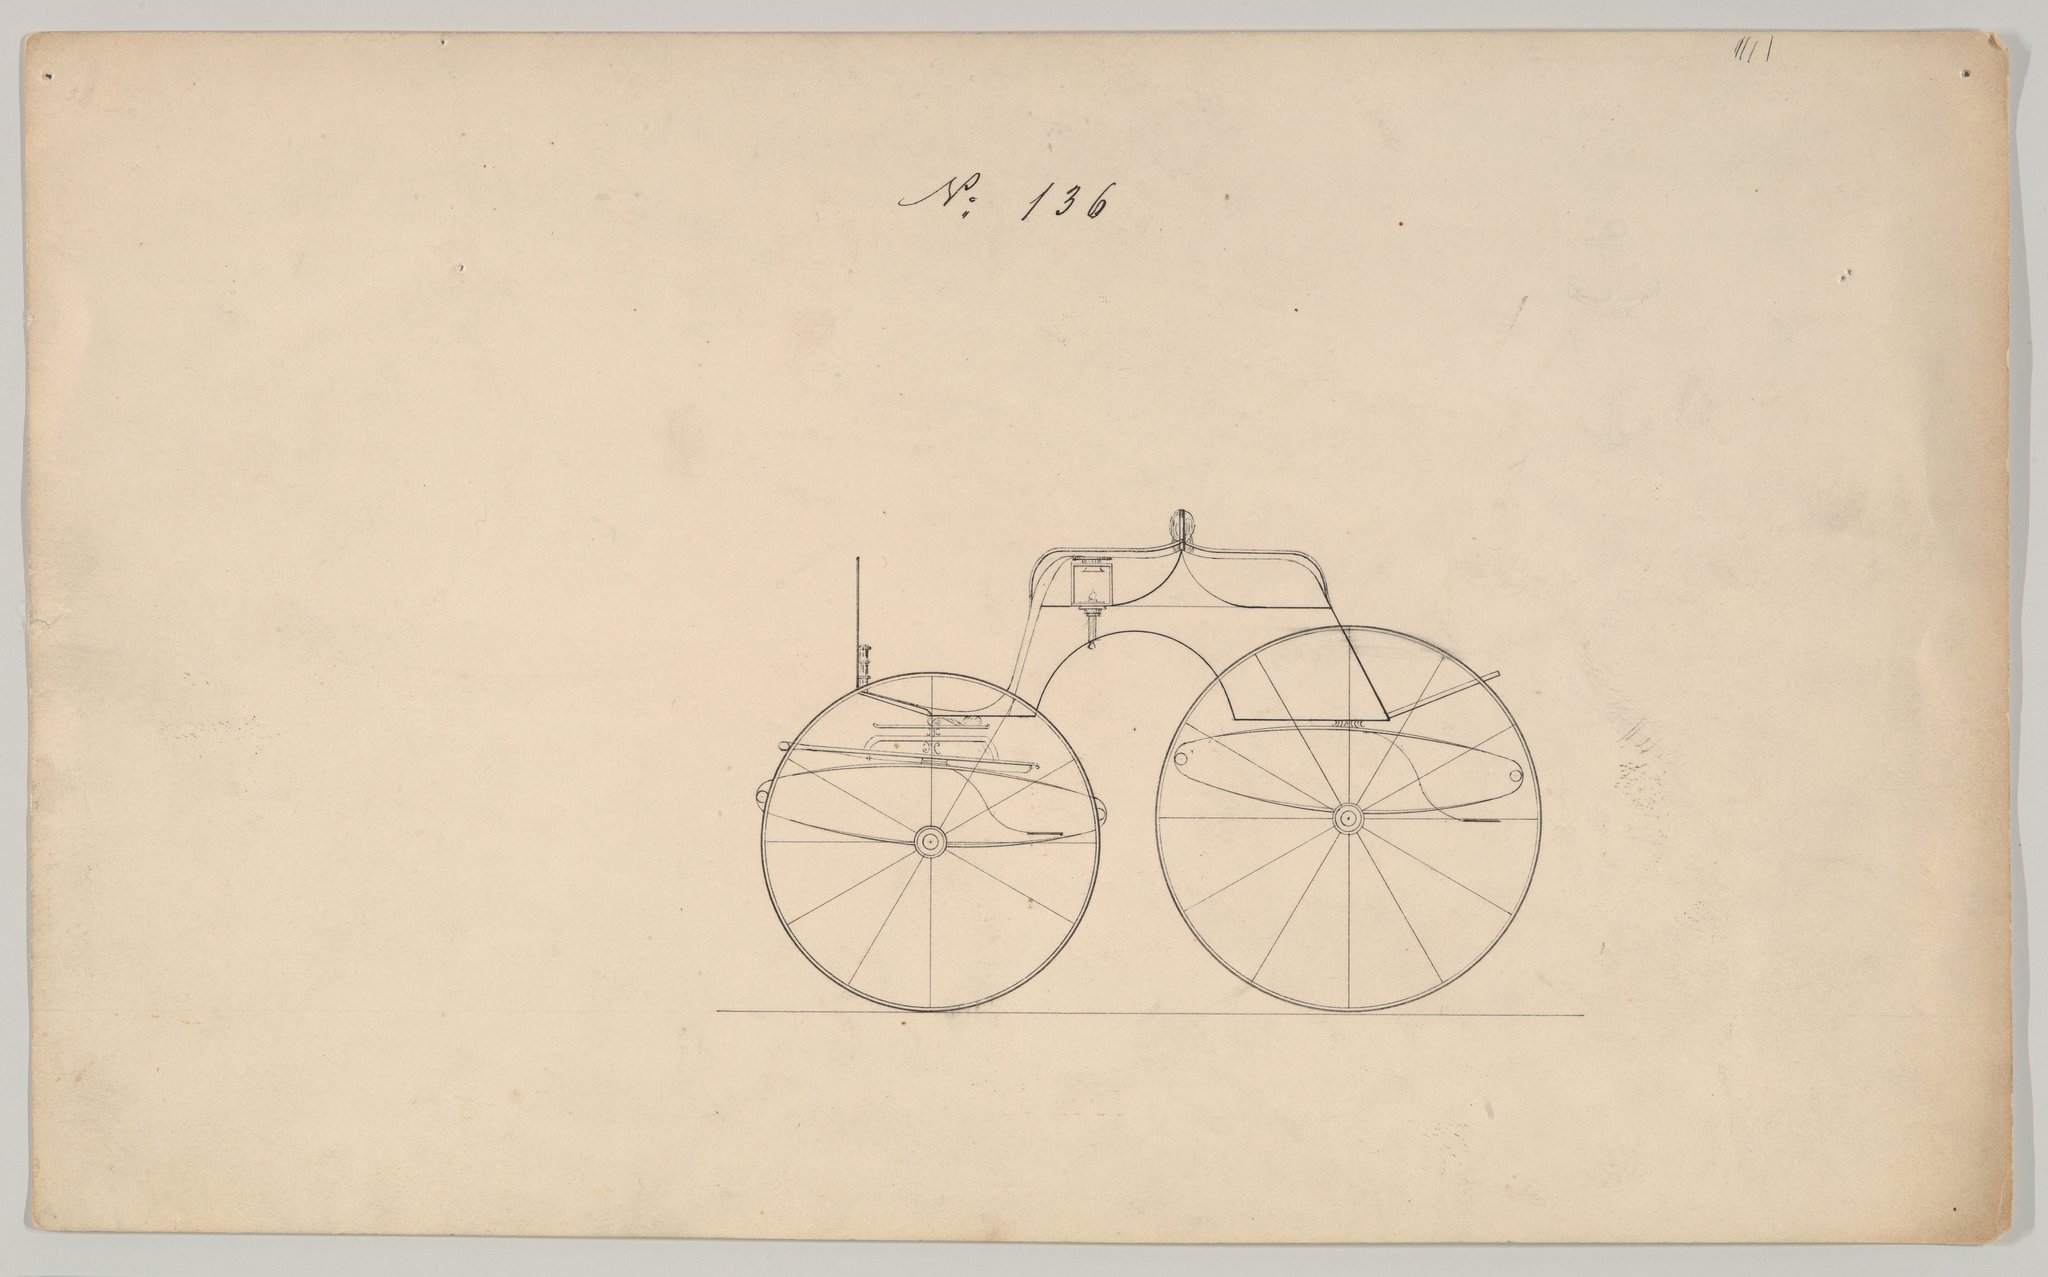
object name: drawing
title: Four Wheel Dog Cart #136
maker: brewster & co.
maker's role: manufacturer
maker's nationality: american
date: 1850-1870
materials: ink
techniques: pen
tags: carriages